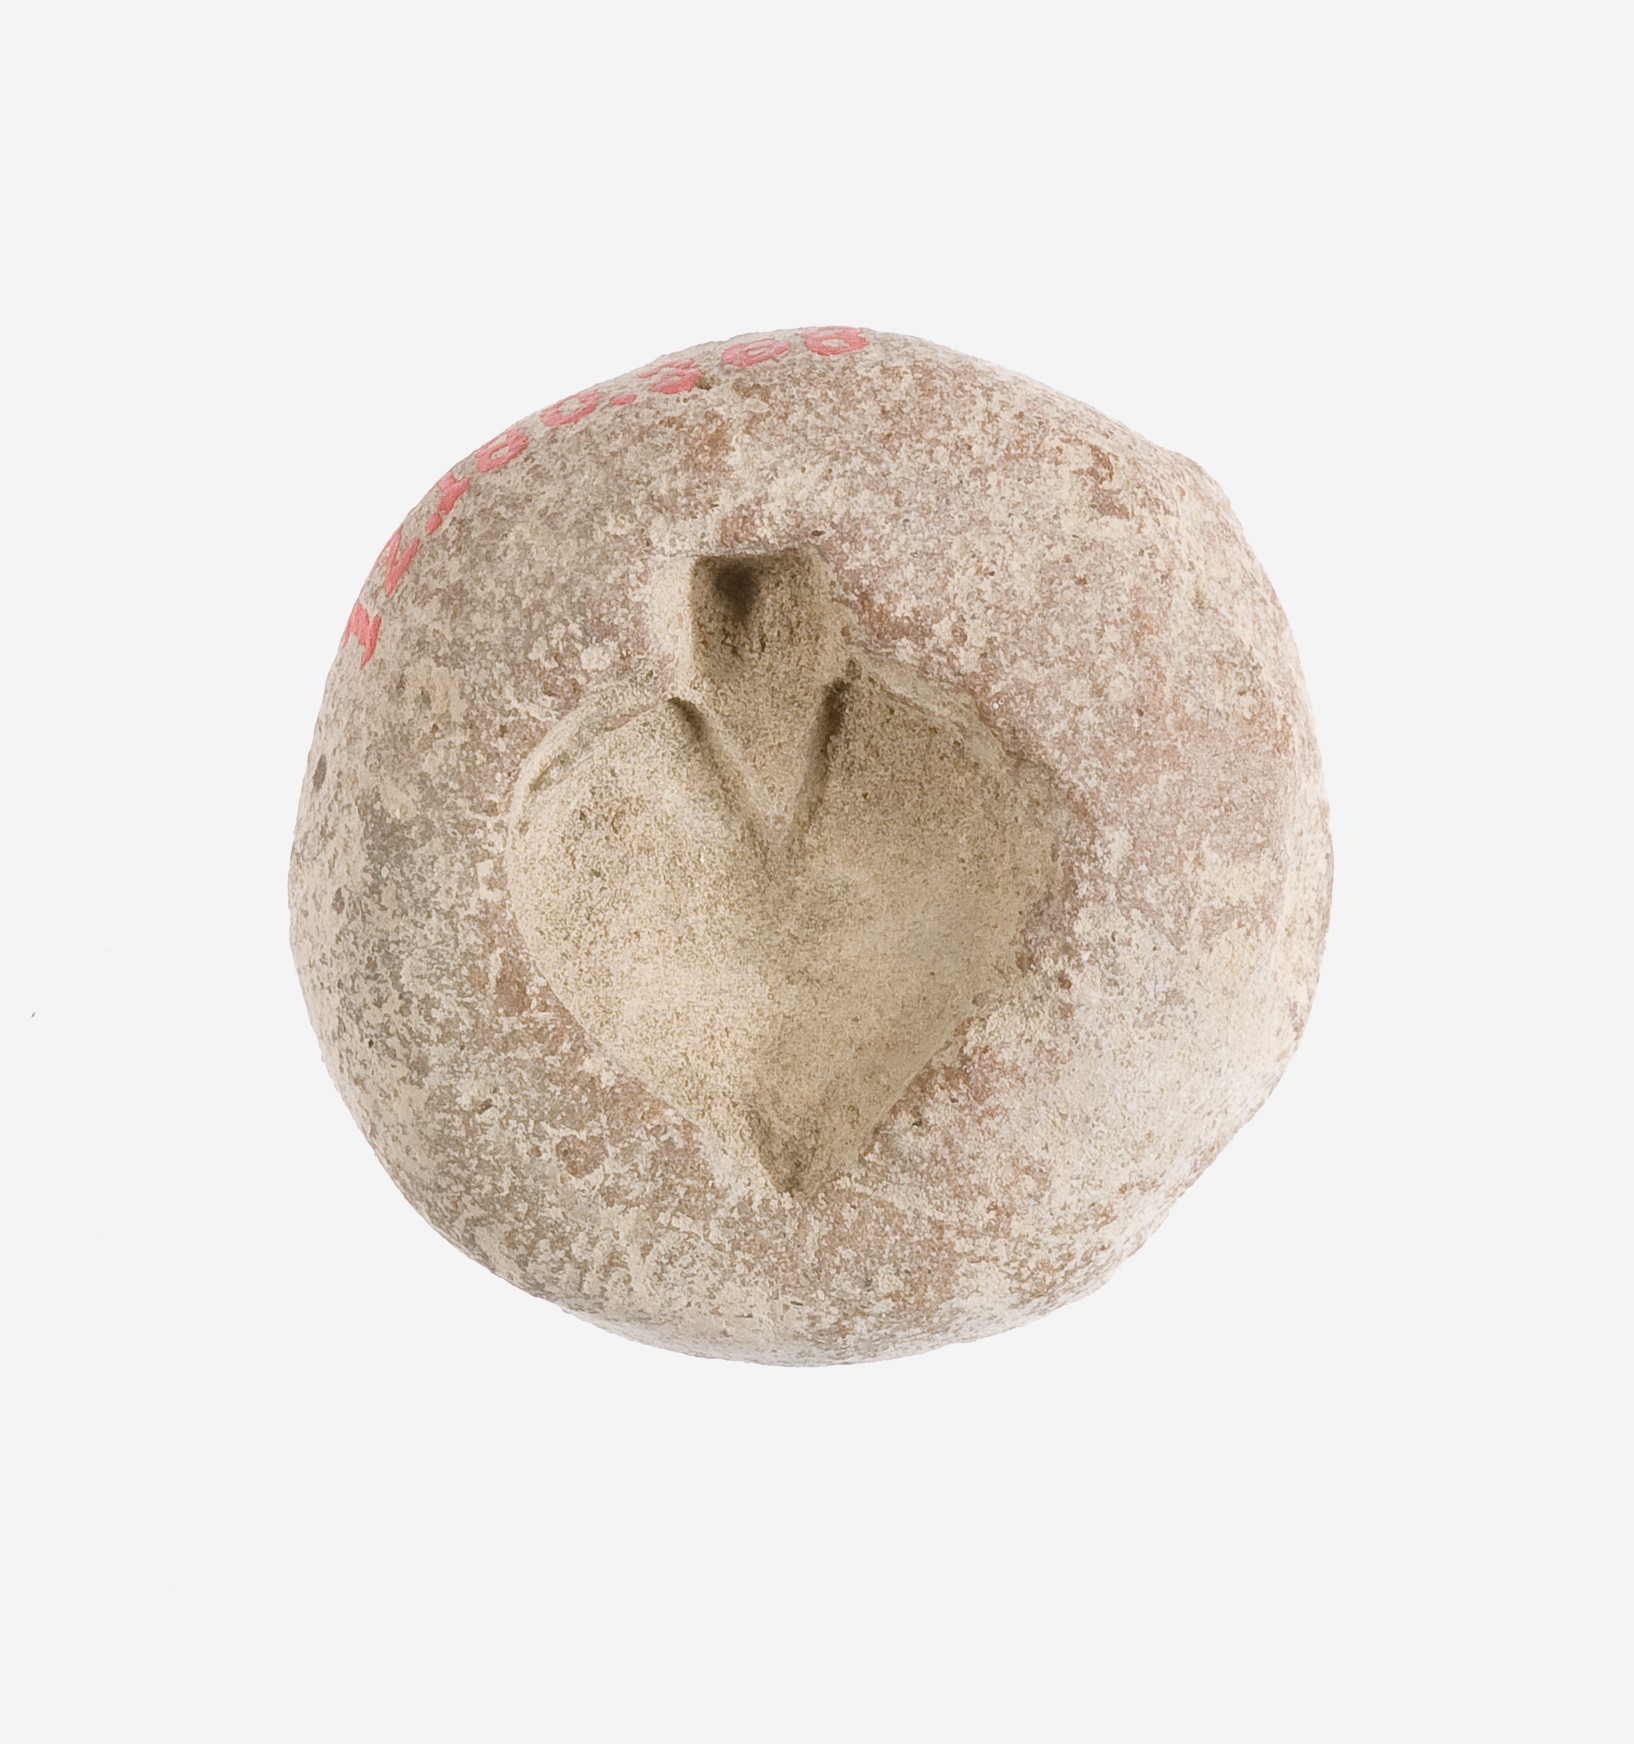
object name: mold, persea fruit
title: Mold for Persea Fruit bead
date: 1390-1352 BCE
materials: pottery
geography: egypt